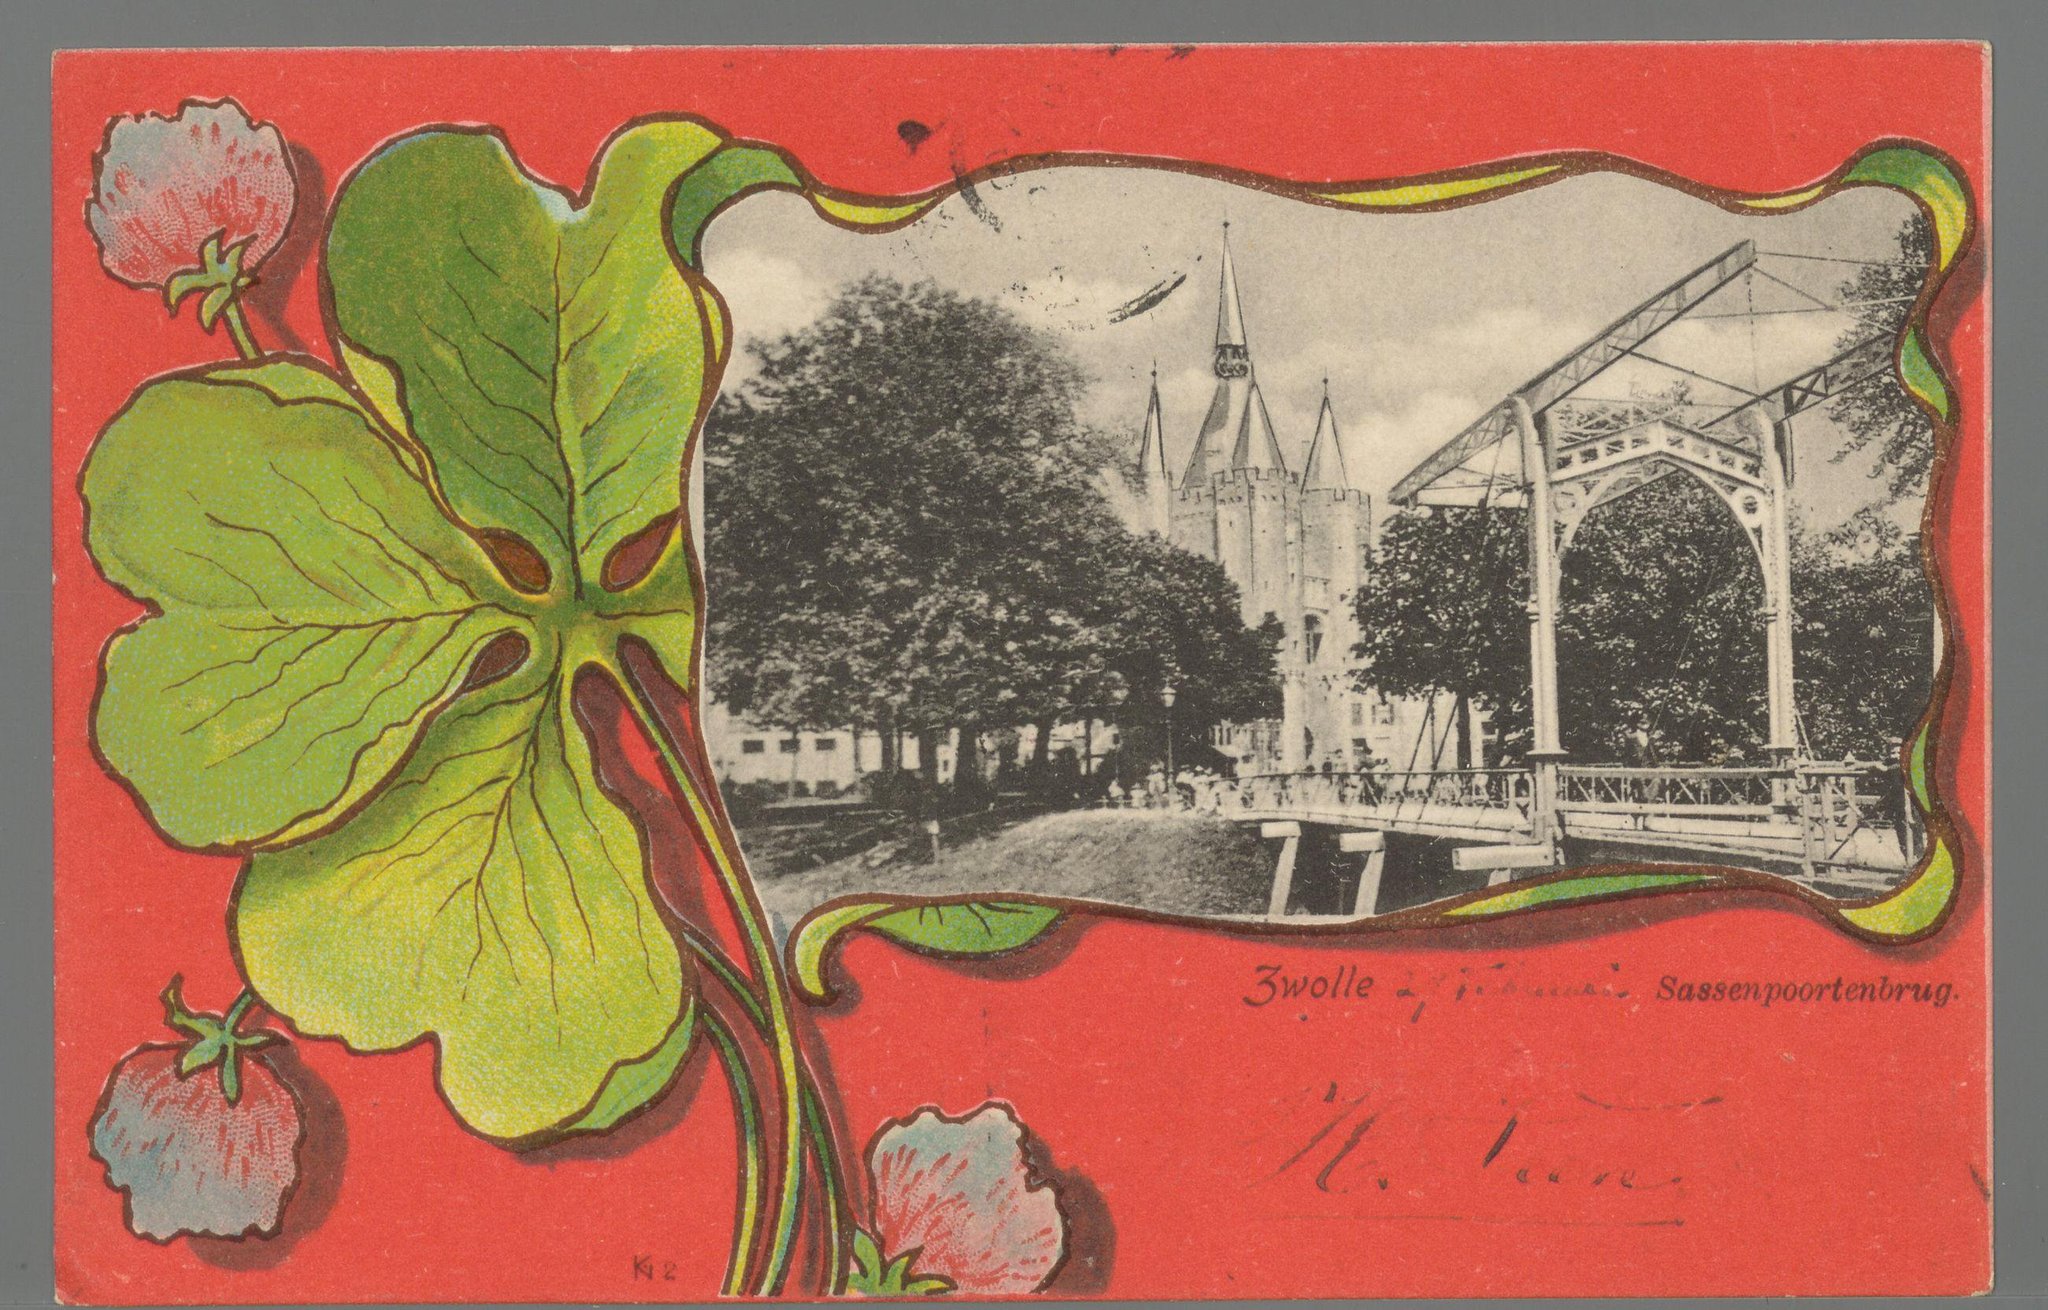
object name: photomechanical print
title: Zwolle Sassenpoortenbrug.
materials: cardboard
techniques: photograph, lithograph, writing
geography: zwolle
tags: bridge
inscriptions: postage stamp